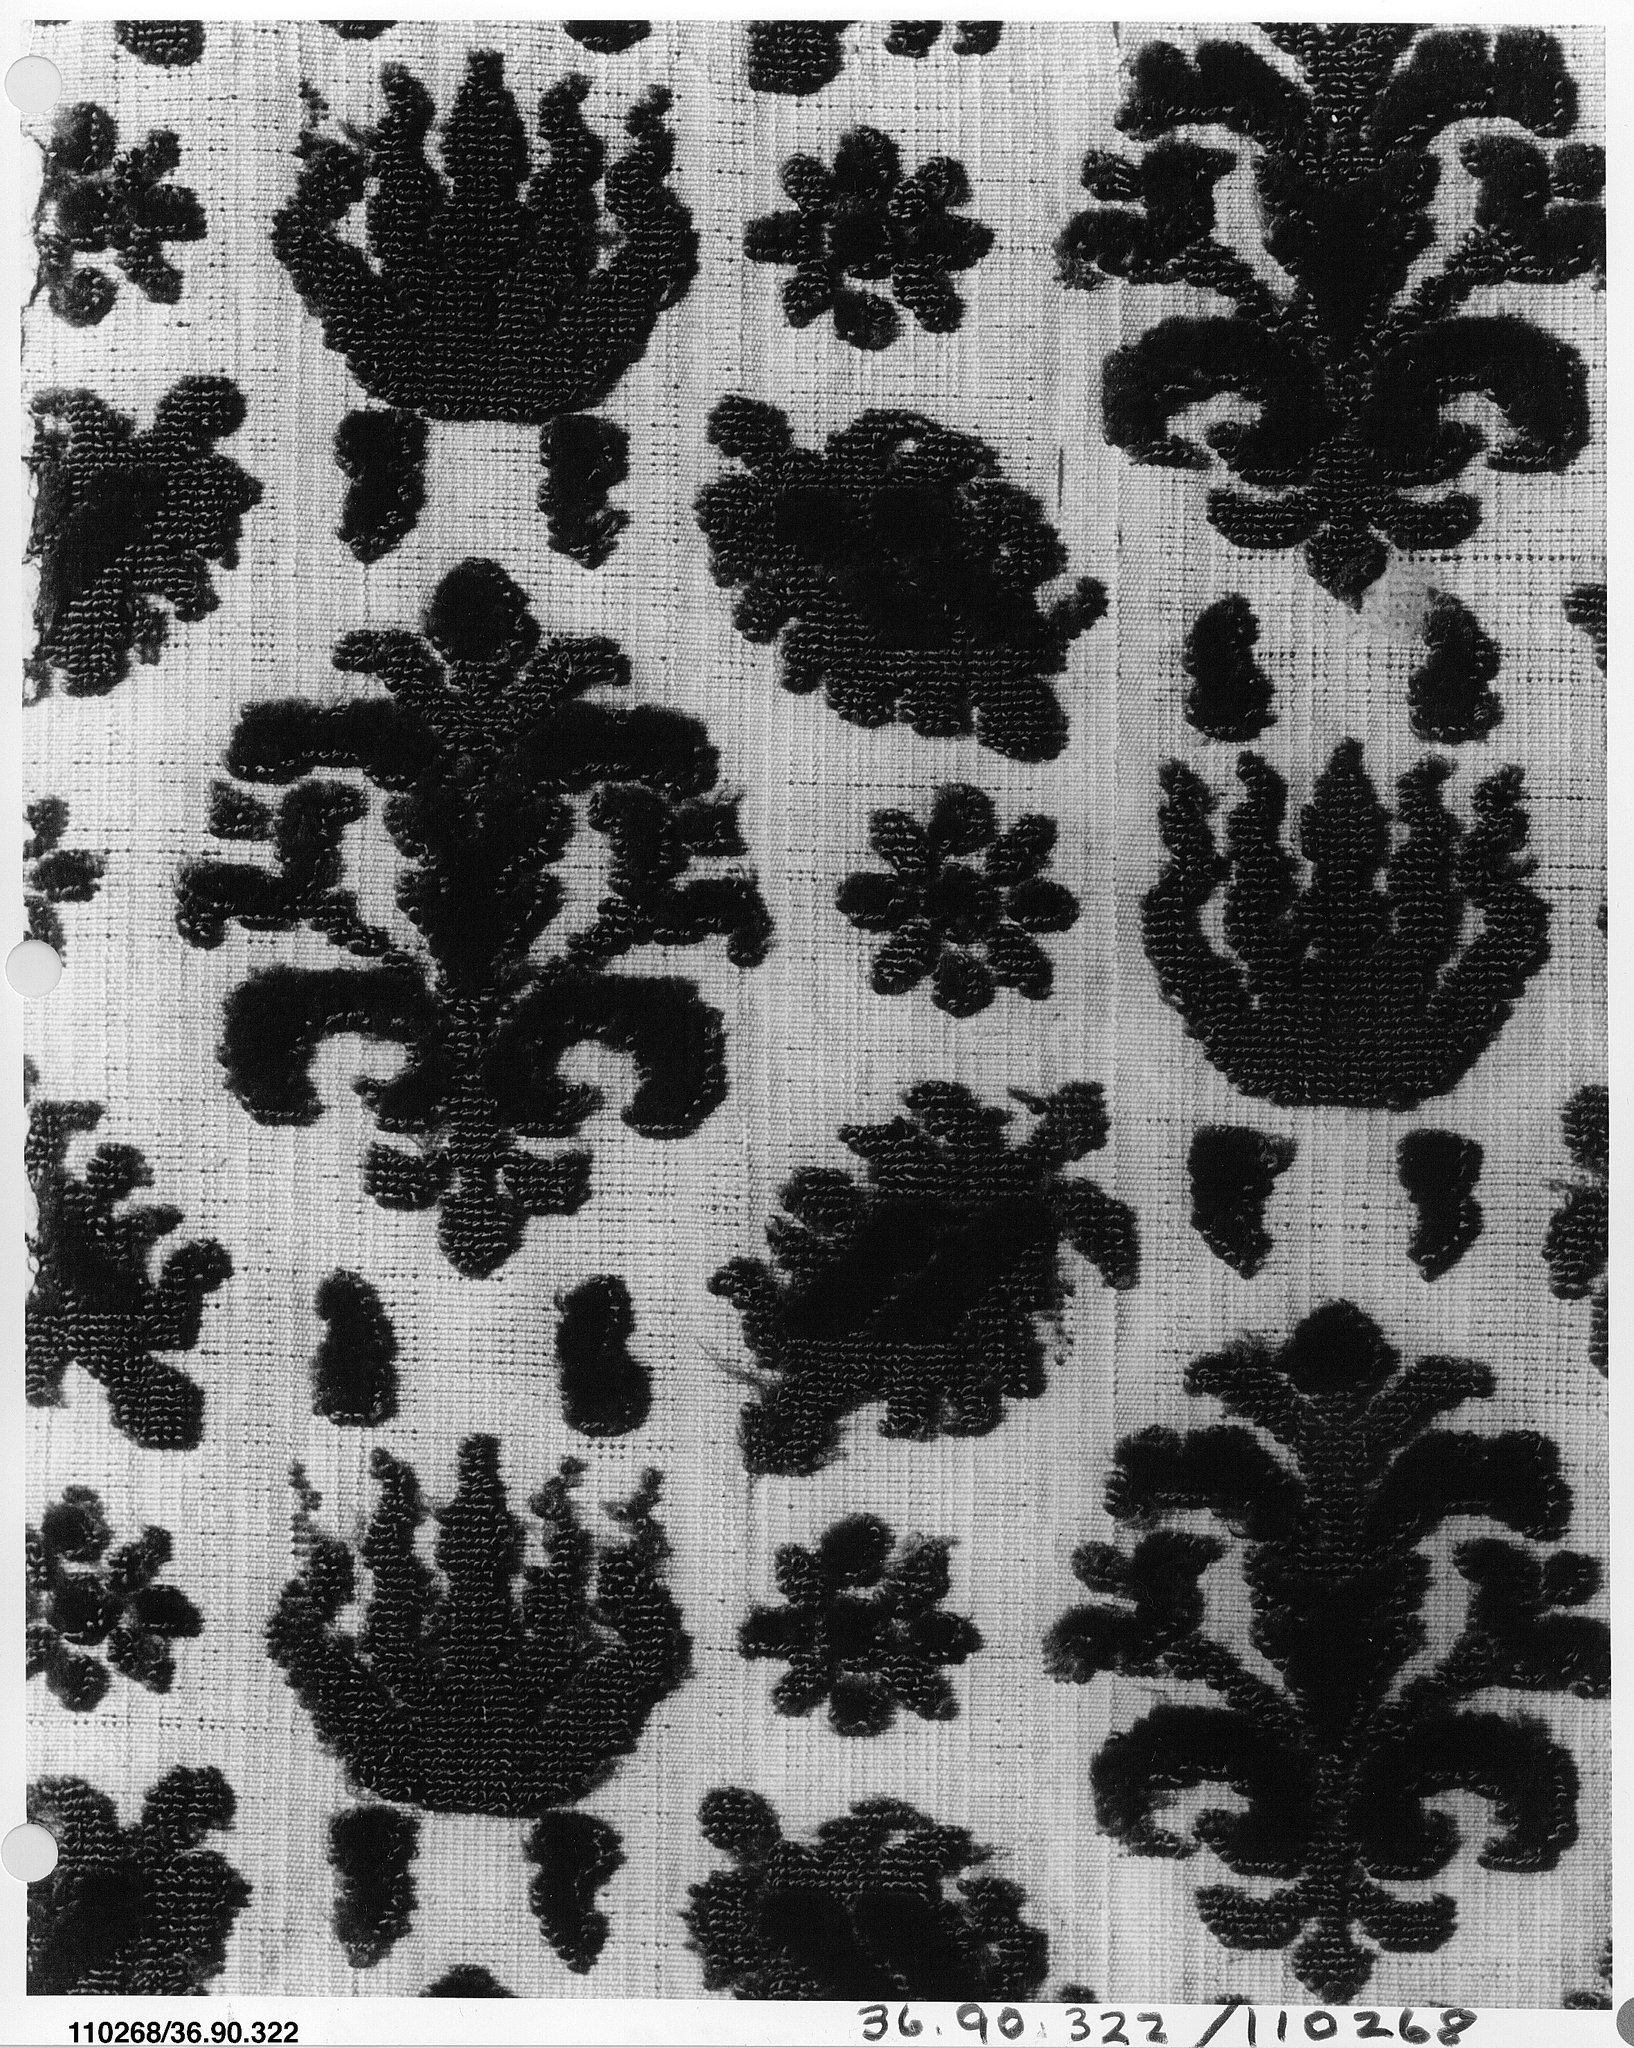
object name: piece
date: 1501-1700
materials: silk